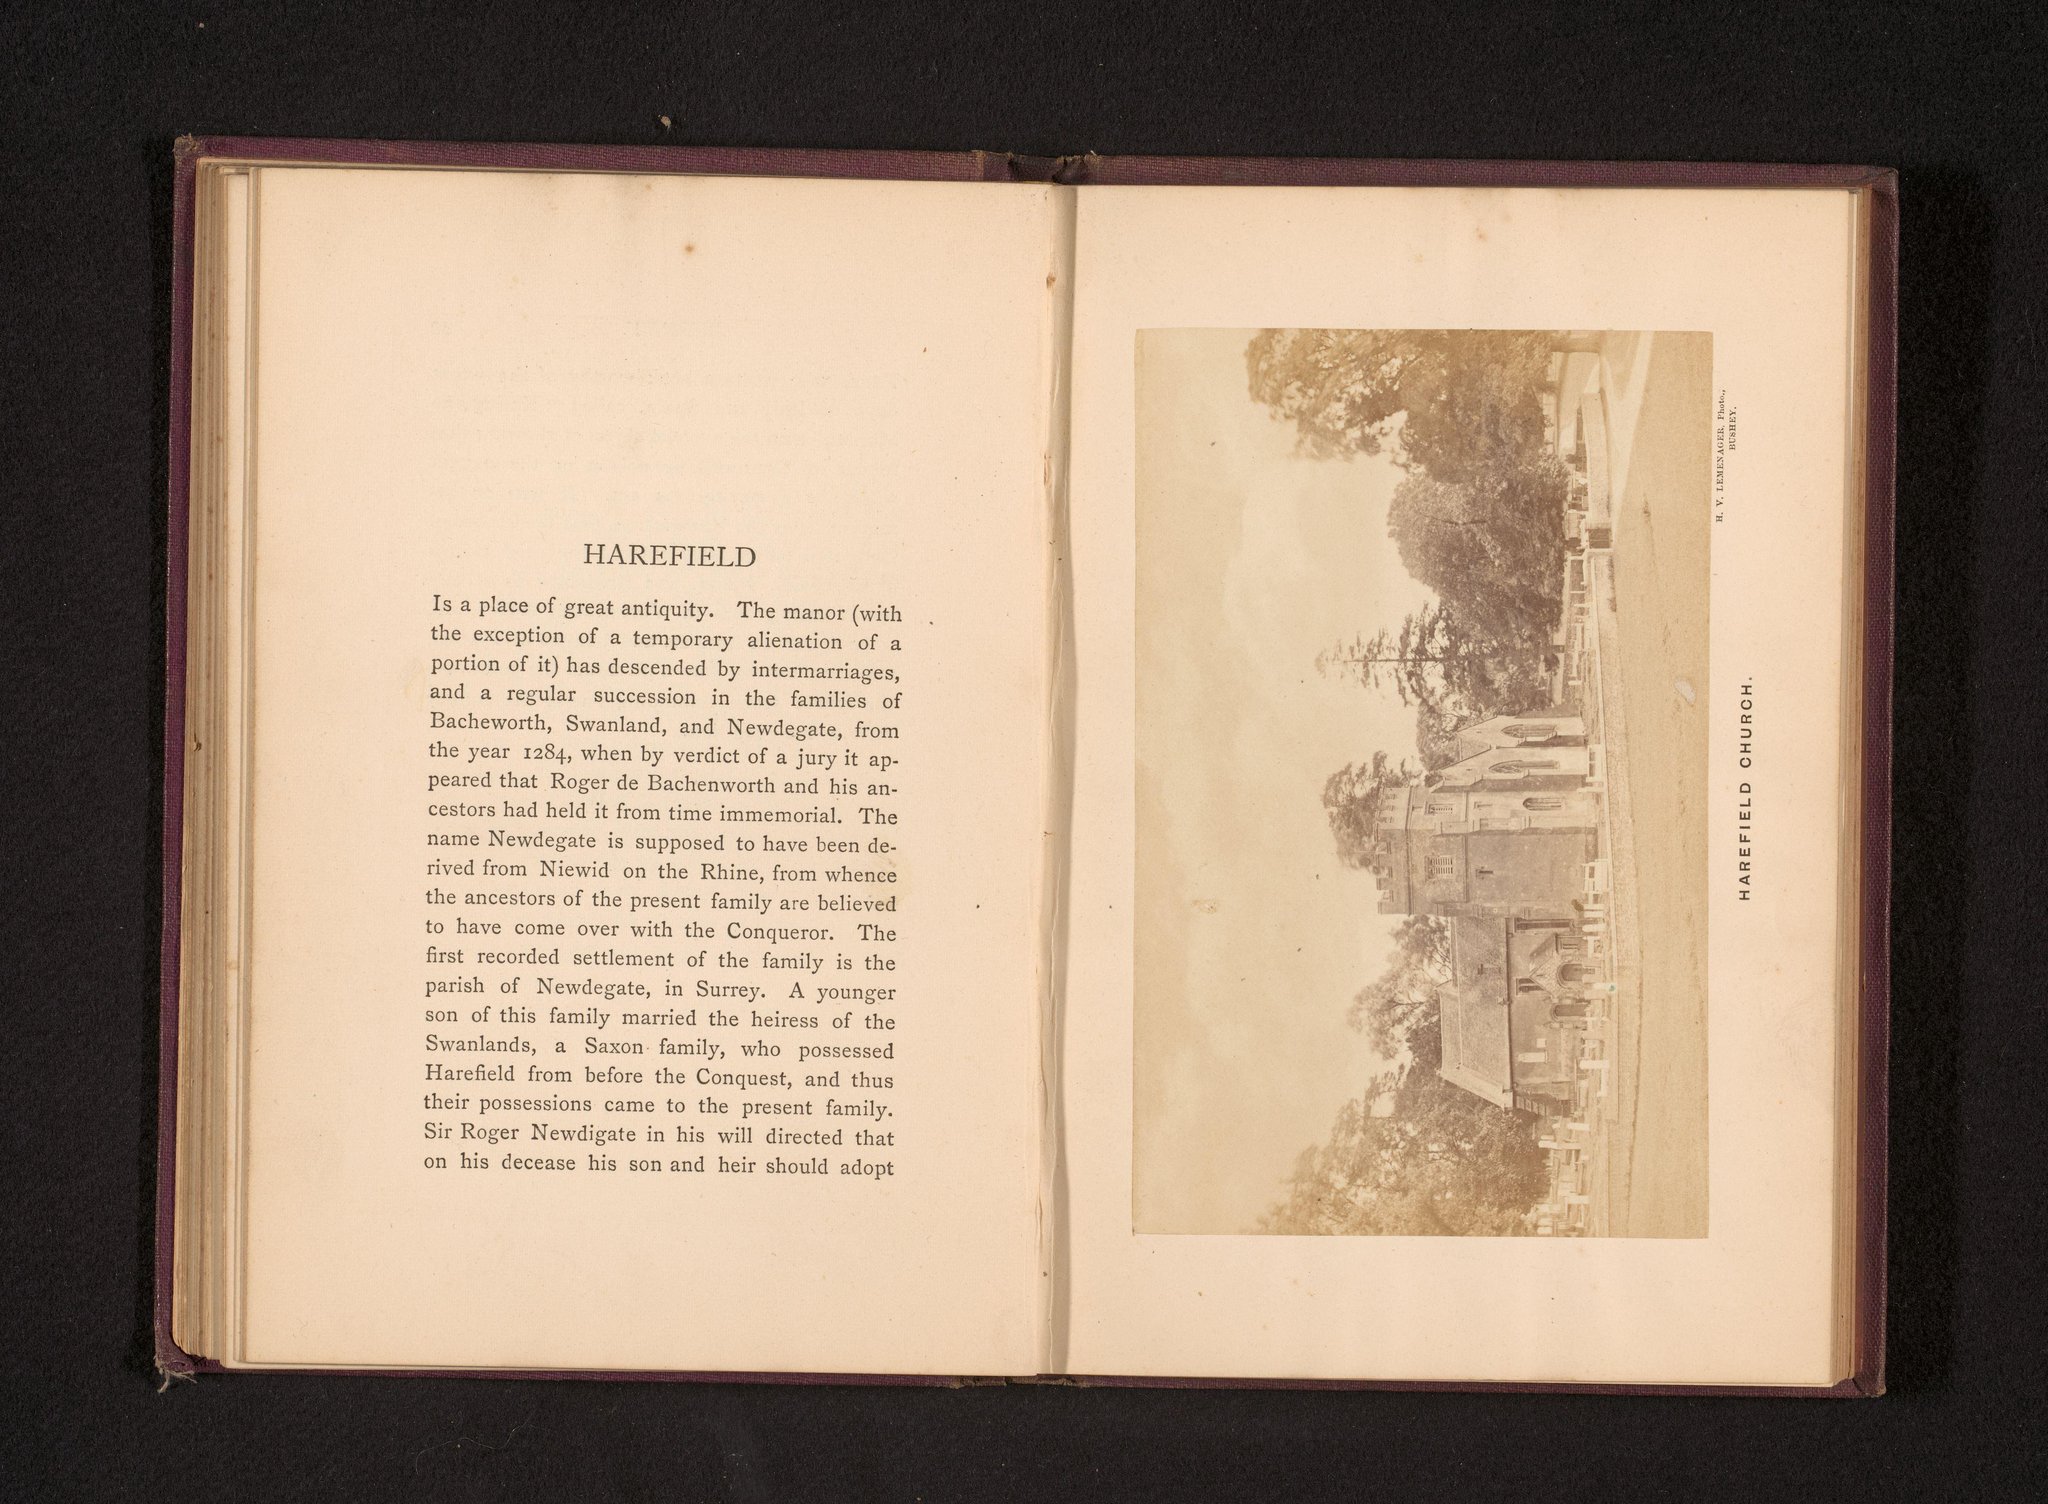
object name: photograph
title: Harefield Church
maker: henri victor leménager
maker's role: docent, fotograaf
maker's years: 1822-1912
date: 1865-1870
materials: photographic support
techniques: albumen print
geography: harefield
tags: church (exterior), civic architecture; edifices; dwellings